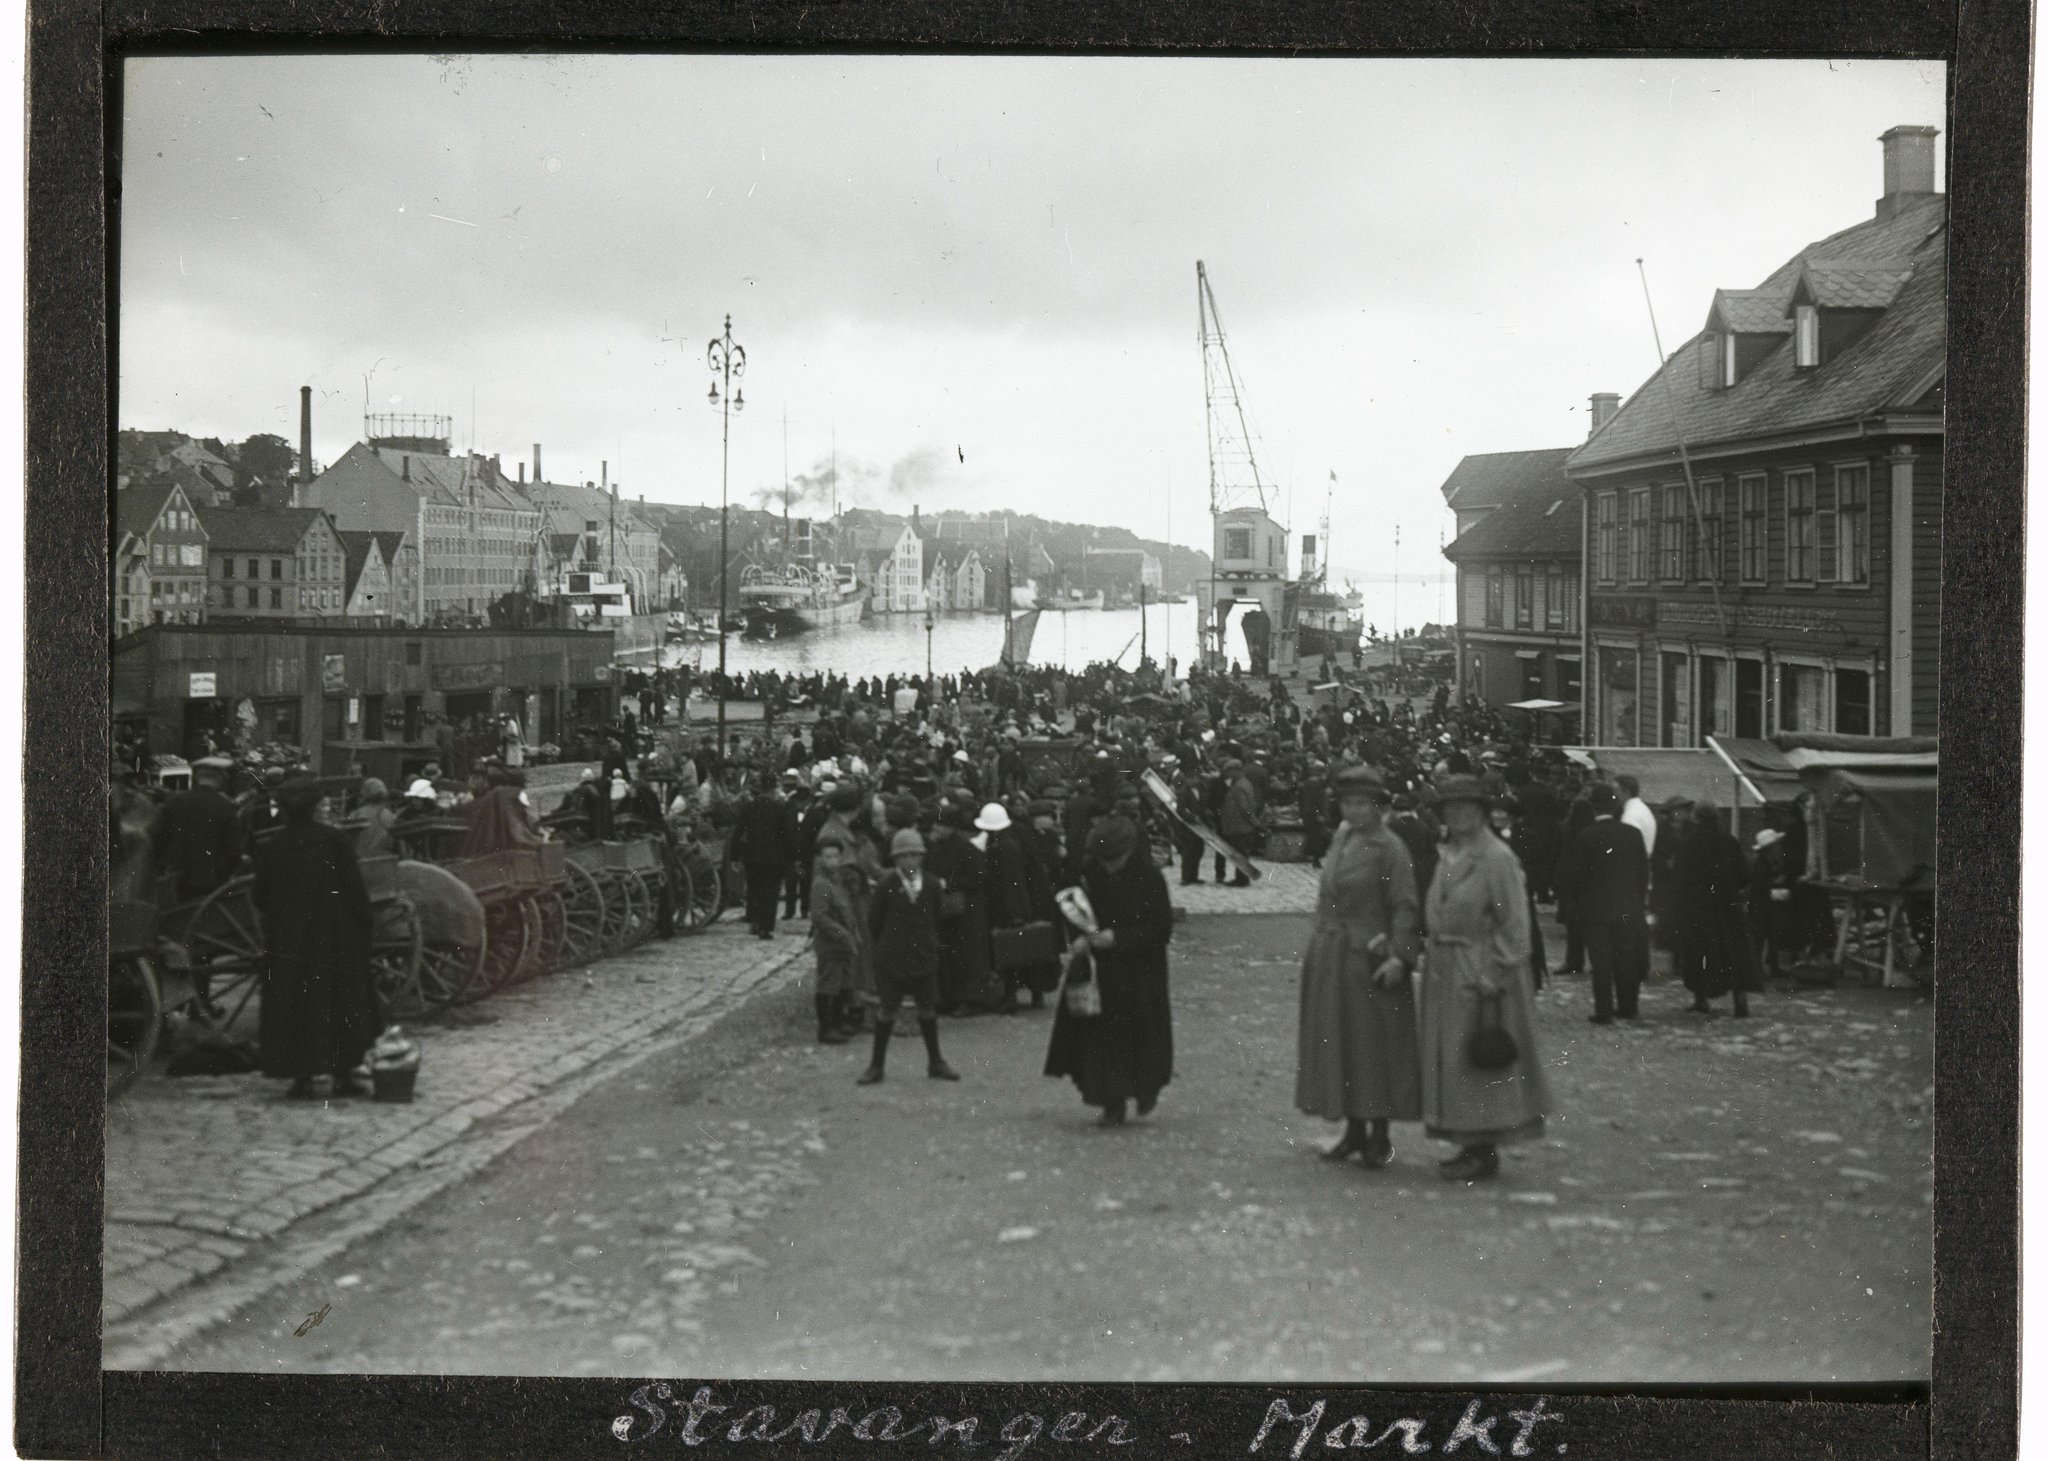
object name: glasdia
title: Mensen bij een markt in Stavanger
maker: Anonymous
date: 1907-1935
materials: glass, ink, paper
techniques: slide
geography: stavanger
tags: crowd, mob, market